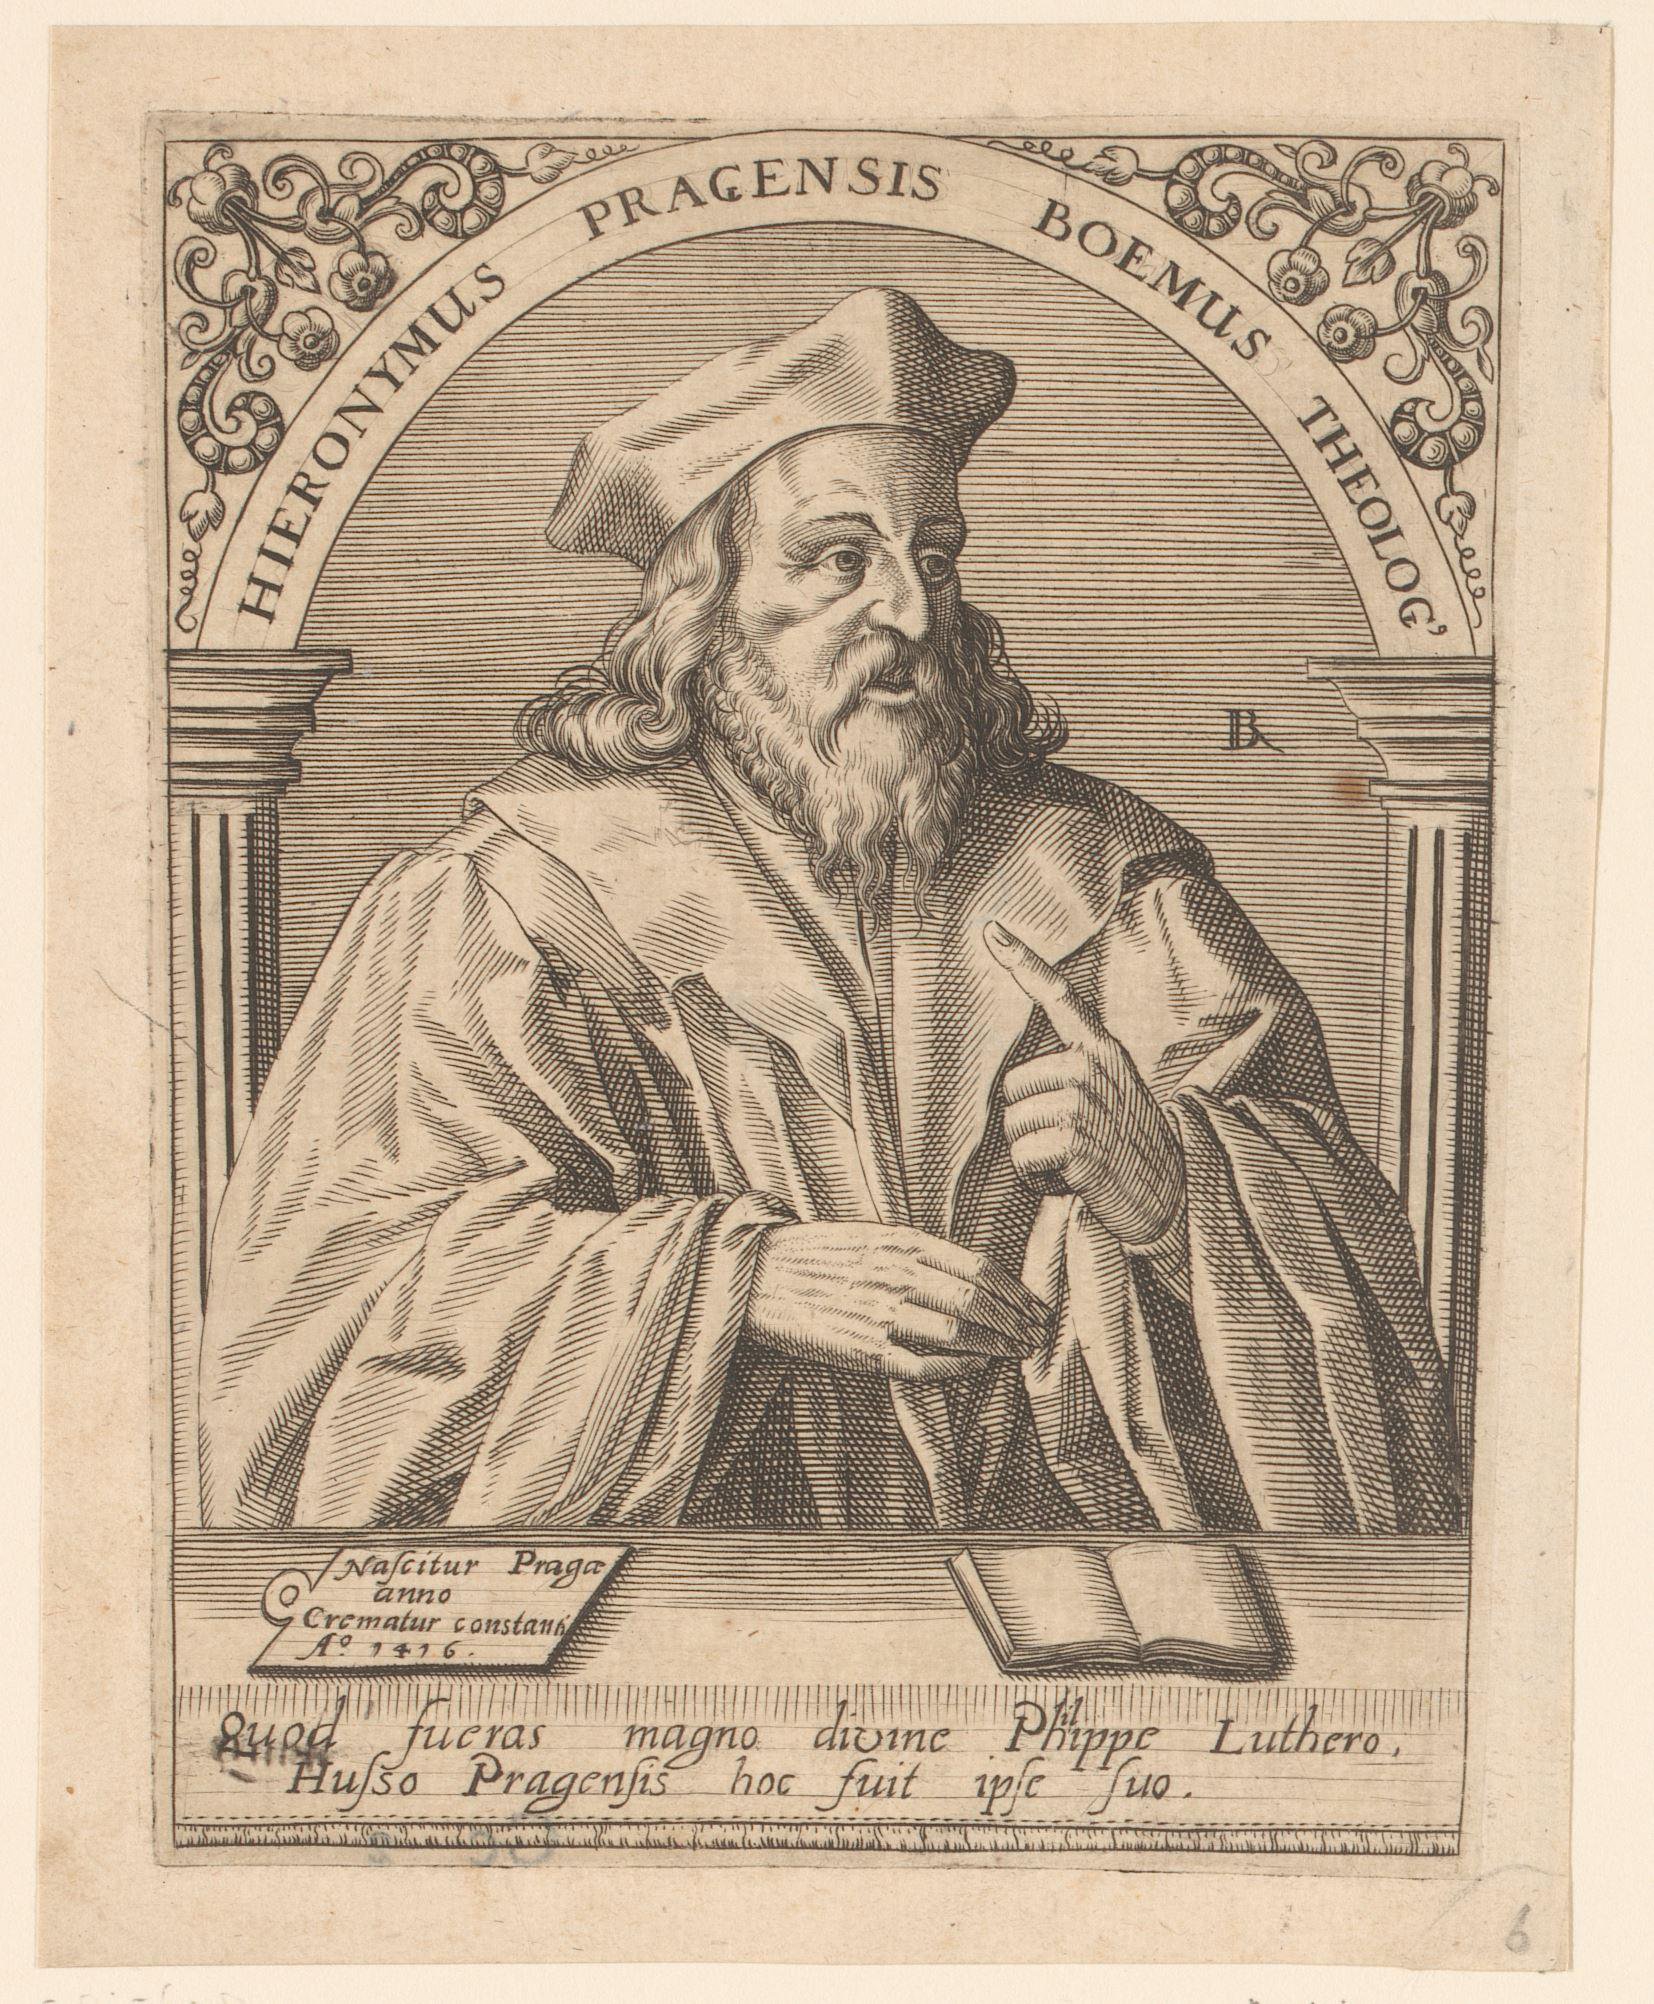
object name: print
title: Portret van Hiëronymus van Praag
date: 1597-1599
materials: paper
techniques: engraving, letterpress printing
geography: france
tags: historical persons, book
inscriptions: collector's mark: Lugt 2228